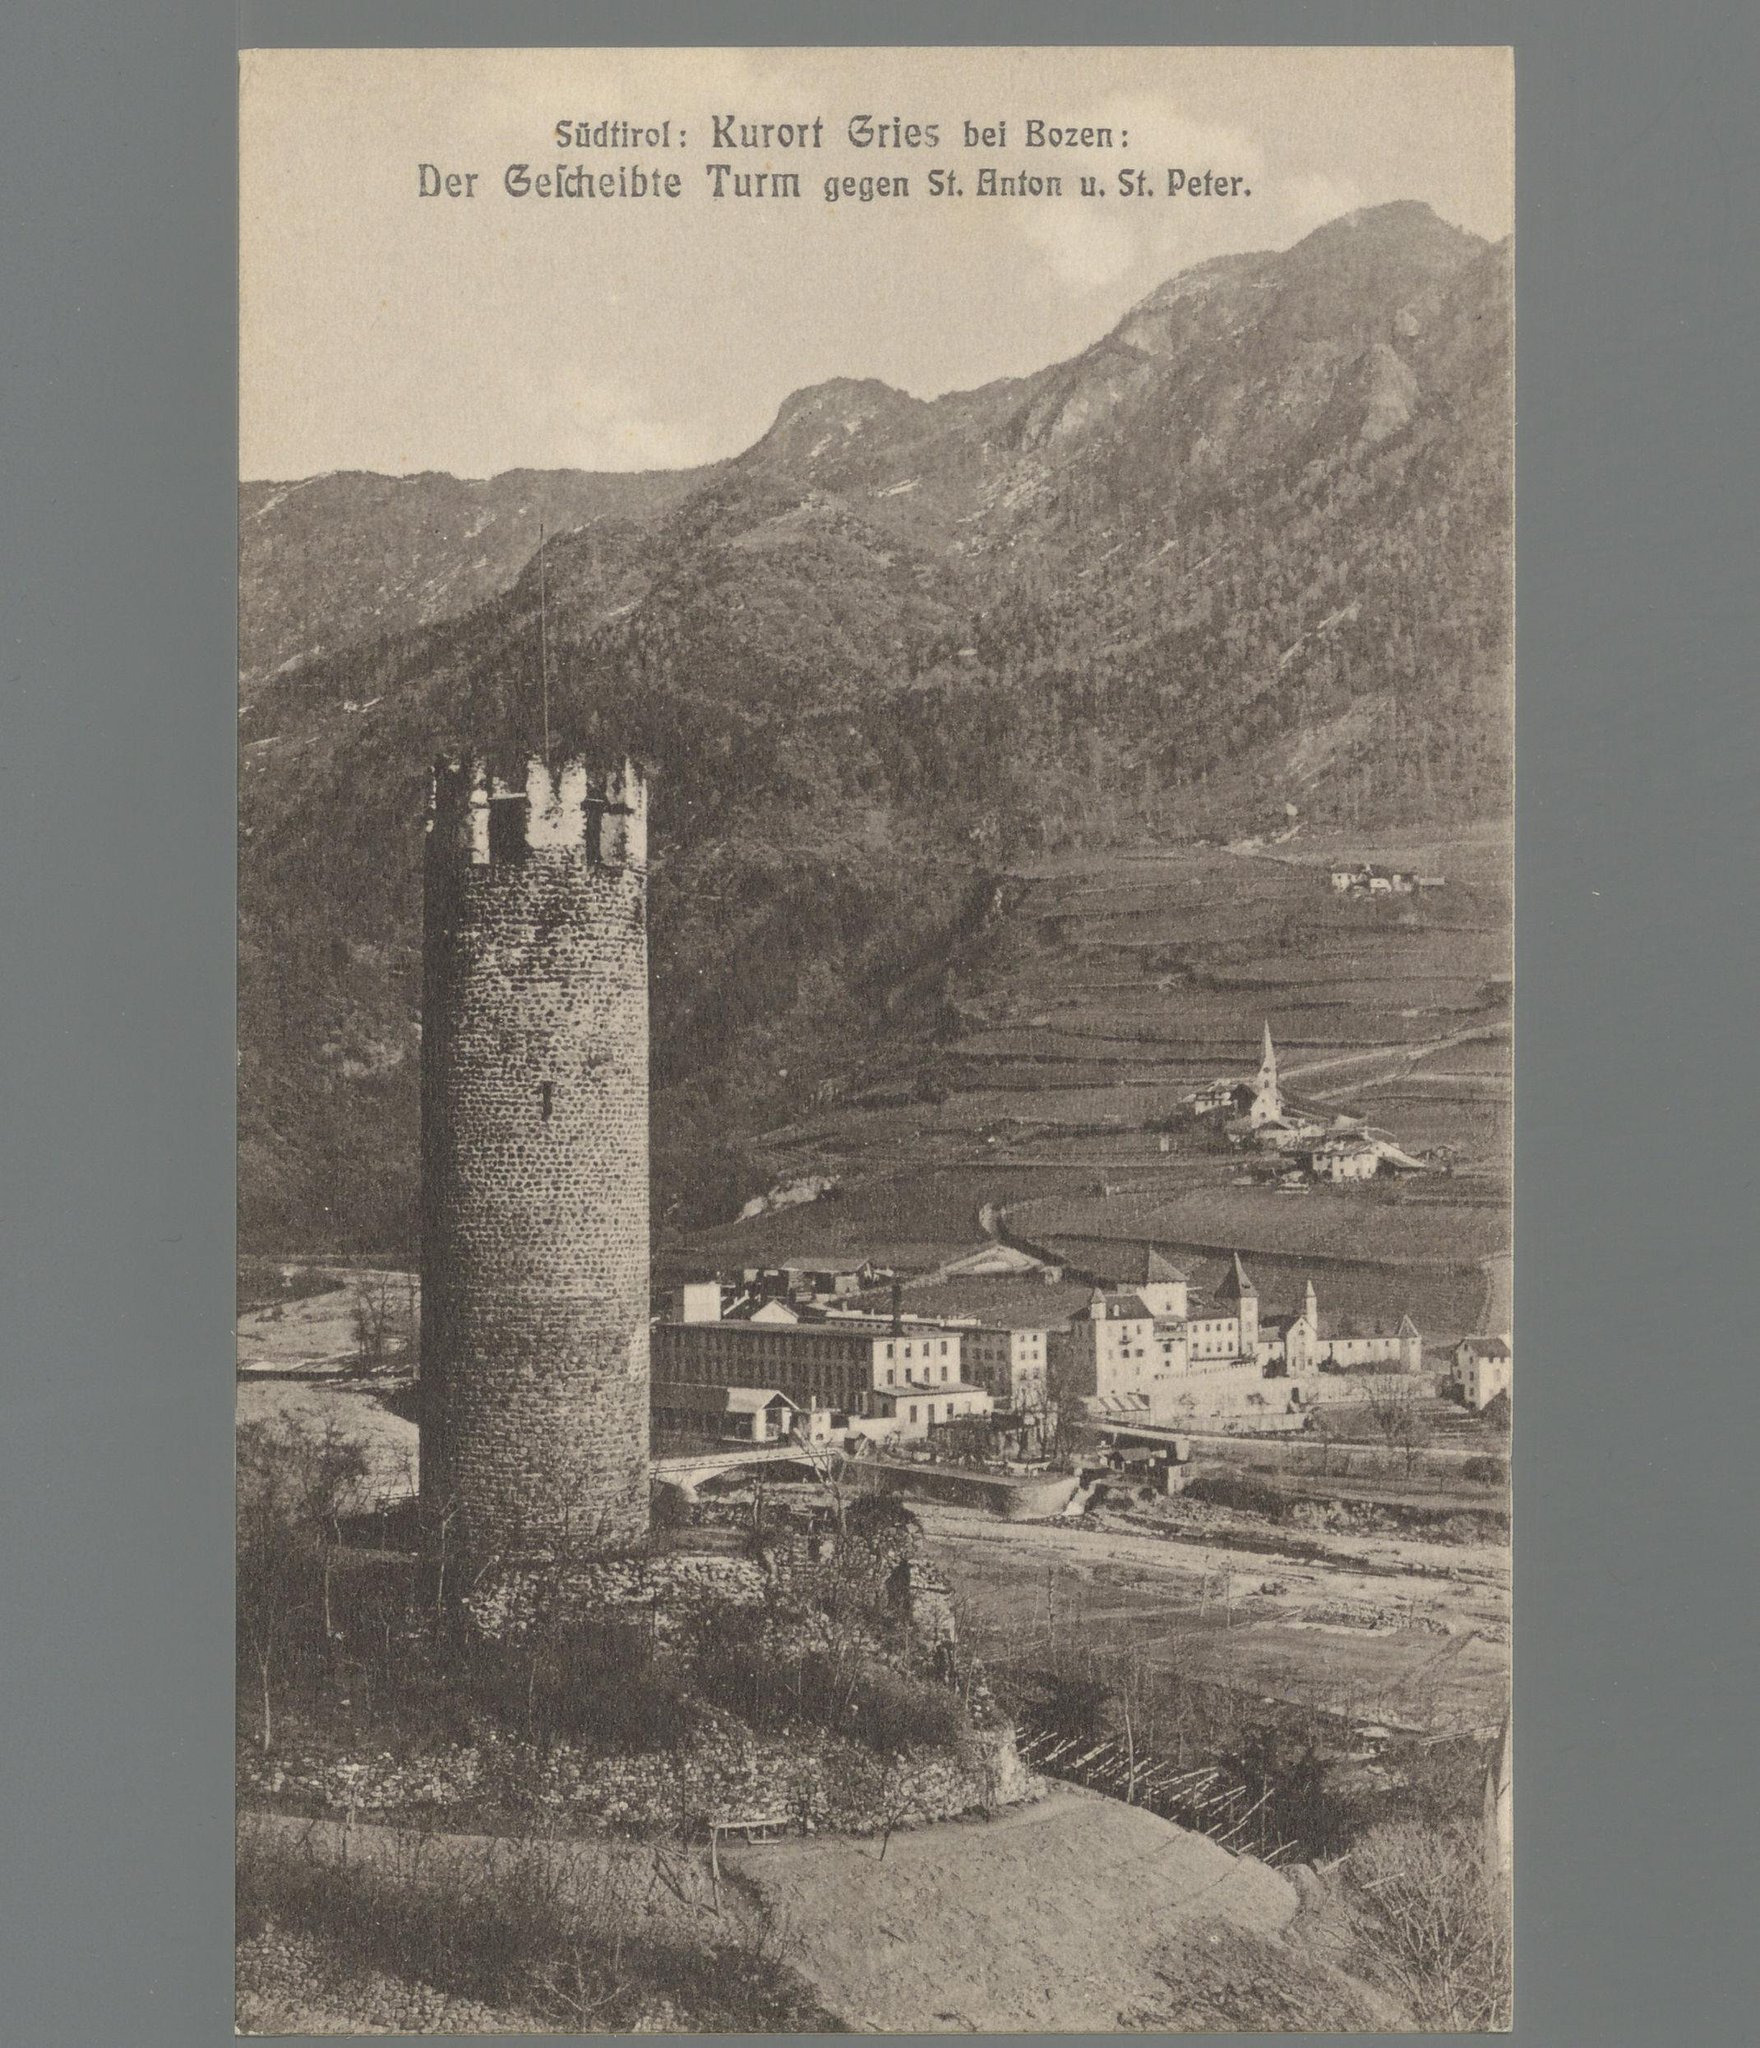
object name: photomechanical print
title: Südtirol. Kurort Gries bei Bozen. Der gescheibte Turm gegen St. Anton und St. Peter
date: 1906-1930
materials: cardboard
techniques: photograph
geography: munich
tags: landscape with tower or castle, mountains